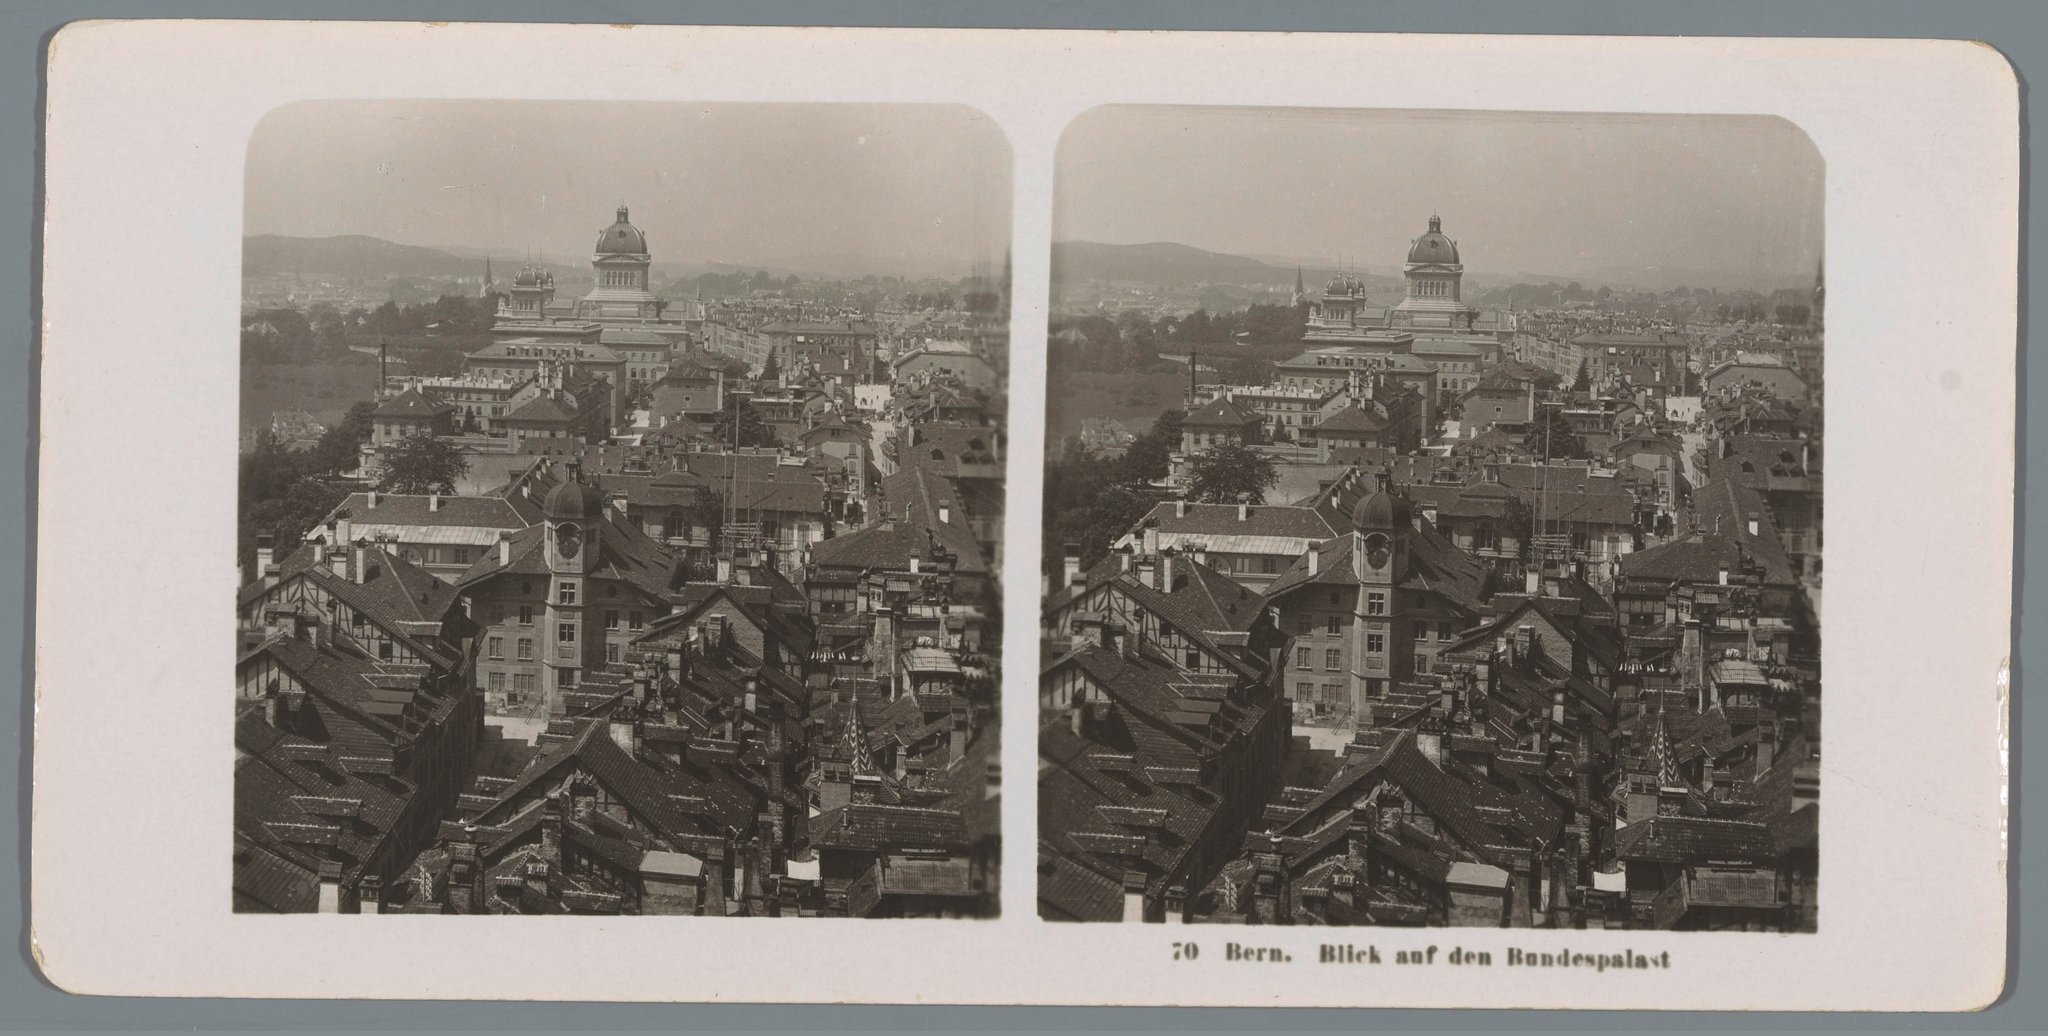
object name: stereograph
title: Bern. Blick auf den Bundespalast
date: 1906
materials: cardboard, photographic support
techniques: gelatin silver print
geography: bern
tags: city-view in general; 'veduta'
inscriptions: inscription: ‘Neue Photographische Gesellschaft A. G., Steglitz-Berlin 1906.’, number: ‘70’